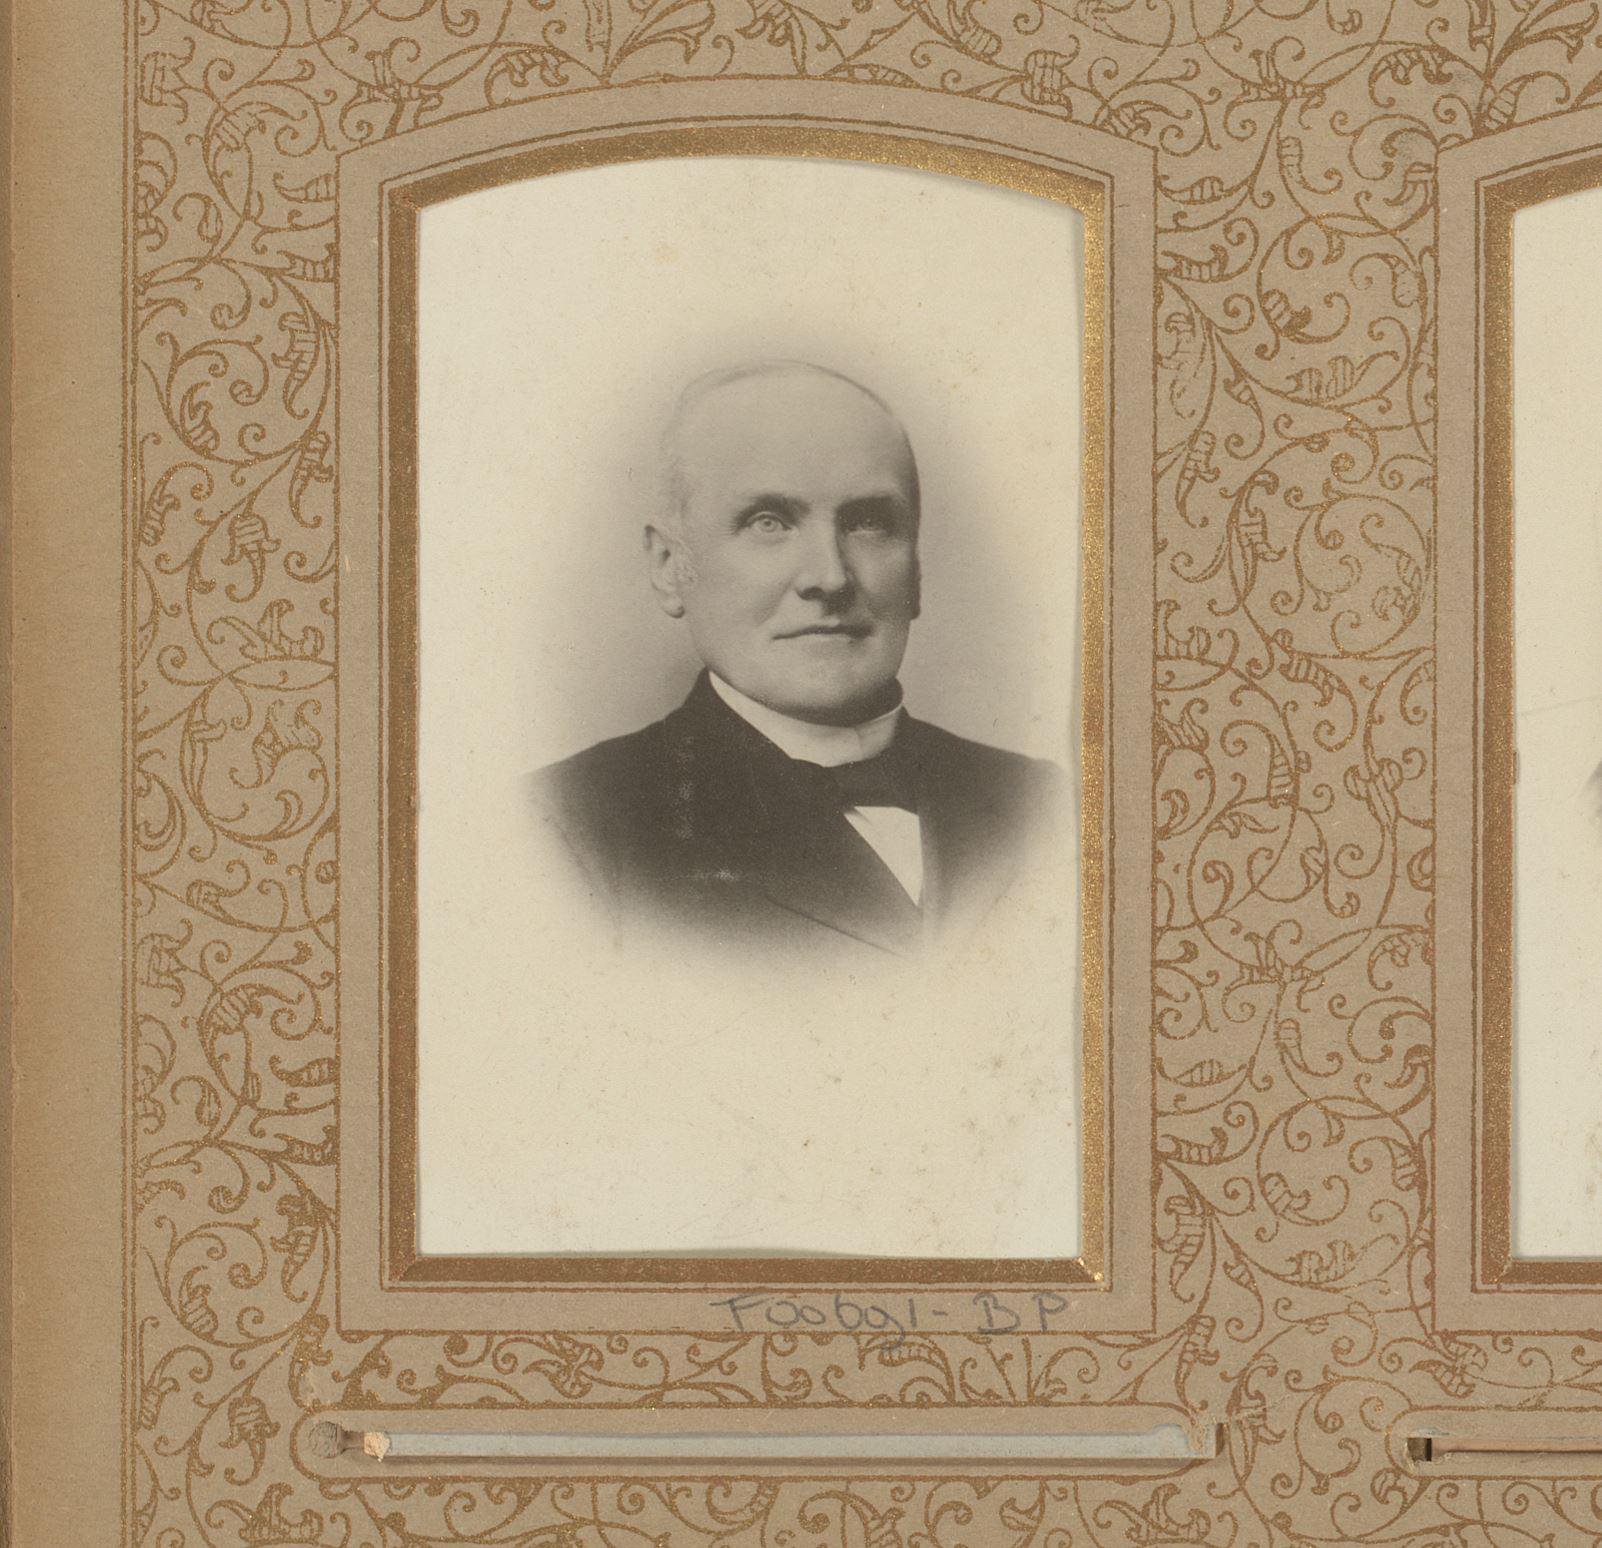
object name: album leaf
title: Portret van een man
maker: f.w. de raad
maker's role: fotograaf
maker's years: 1869-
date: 1910-1930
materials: photographic support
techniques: gelatin silver print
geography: leiden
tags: historical persons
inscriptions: inscription: ‘F.W. de Raad/ Hooigracht 86/ Leiden’